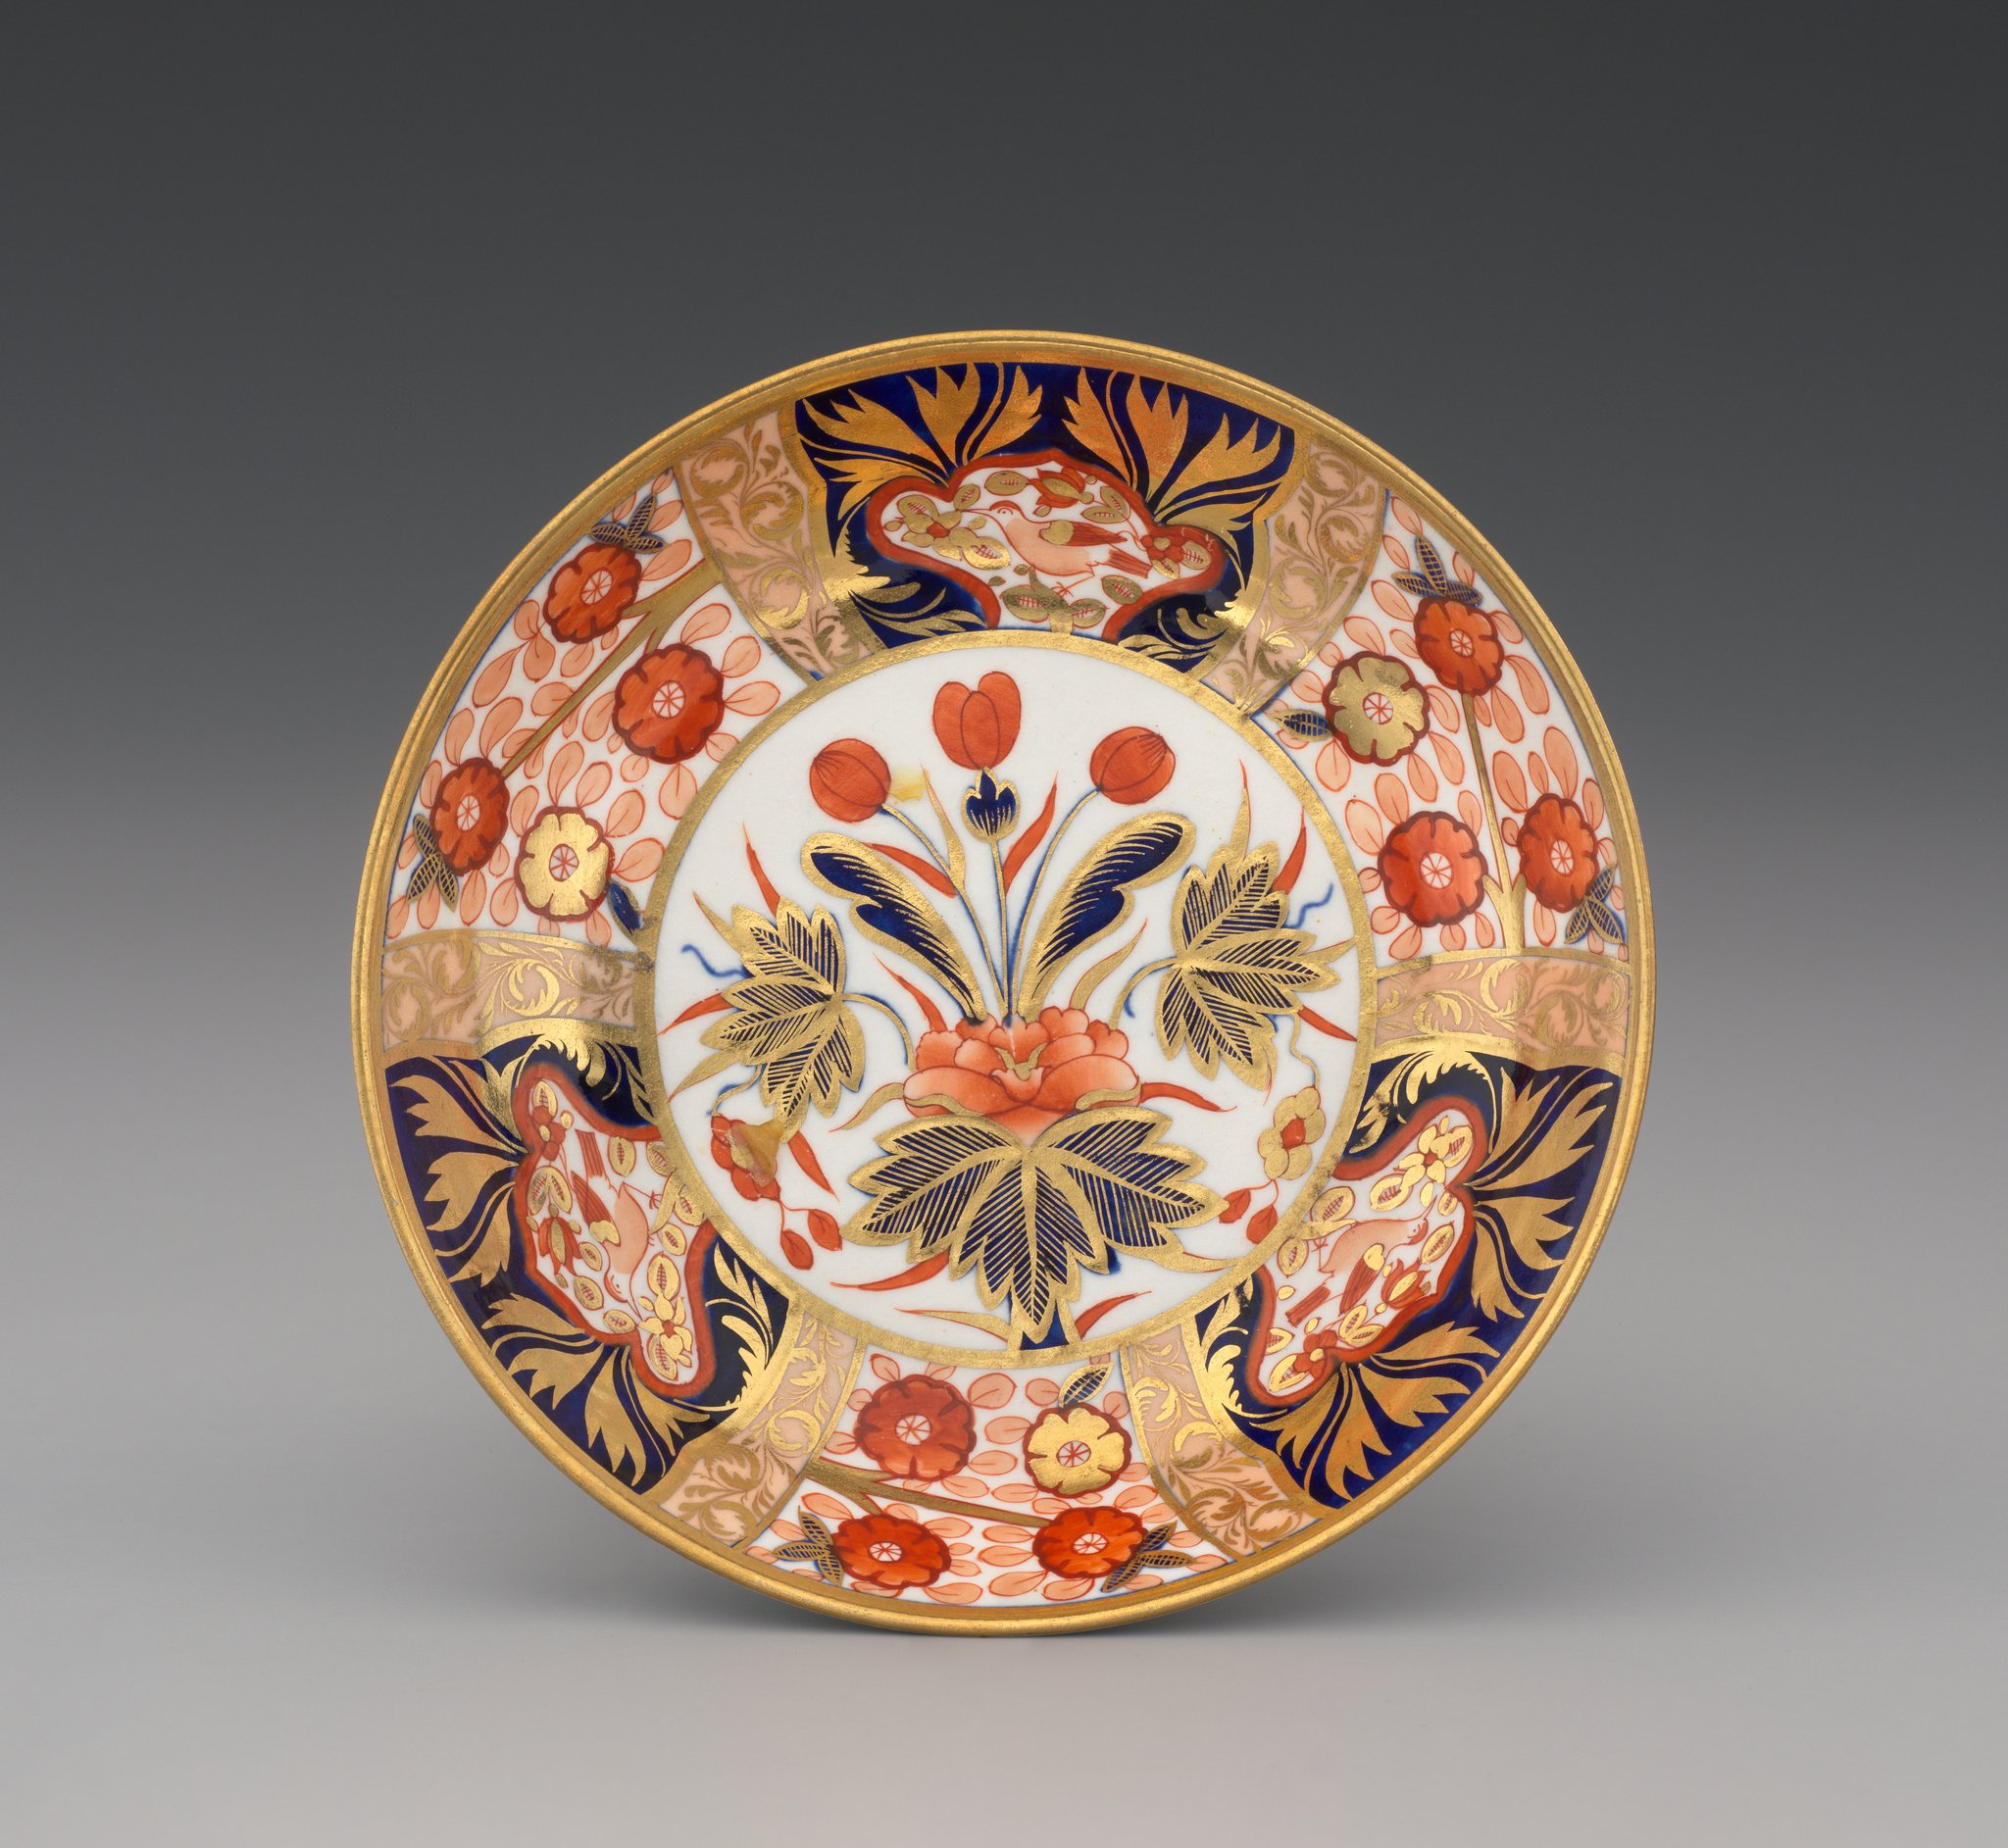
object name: saucer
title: Saucer (part of a service)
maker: j. spode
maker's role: factory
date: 1800-1830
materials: soft paste porcelain